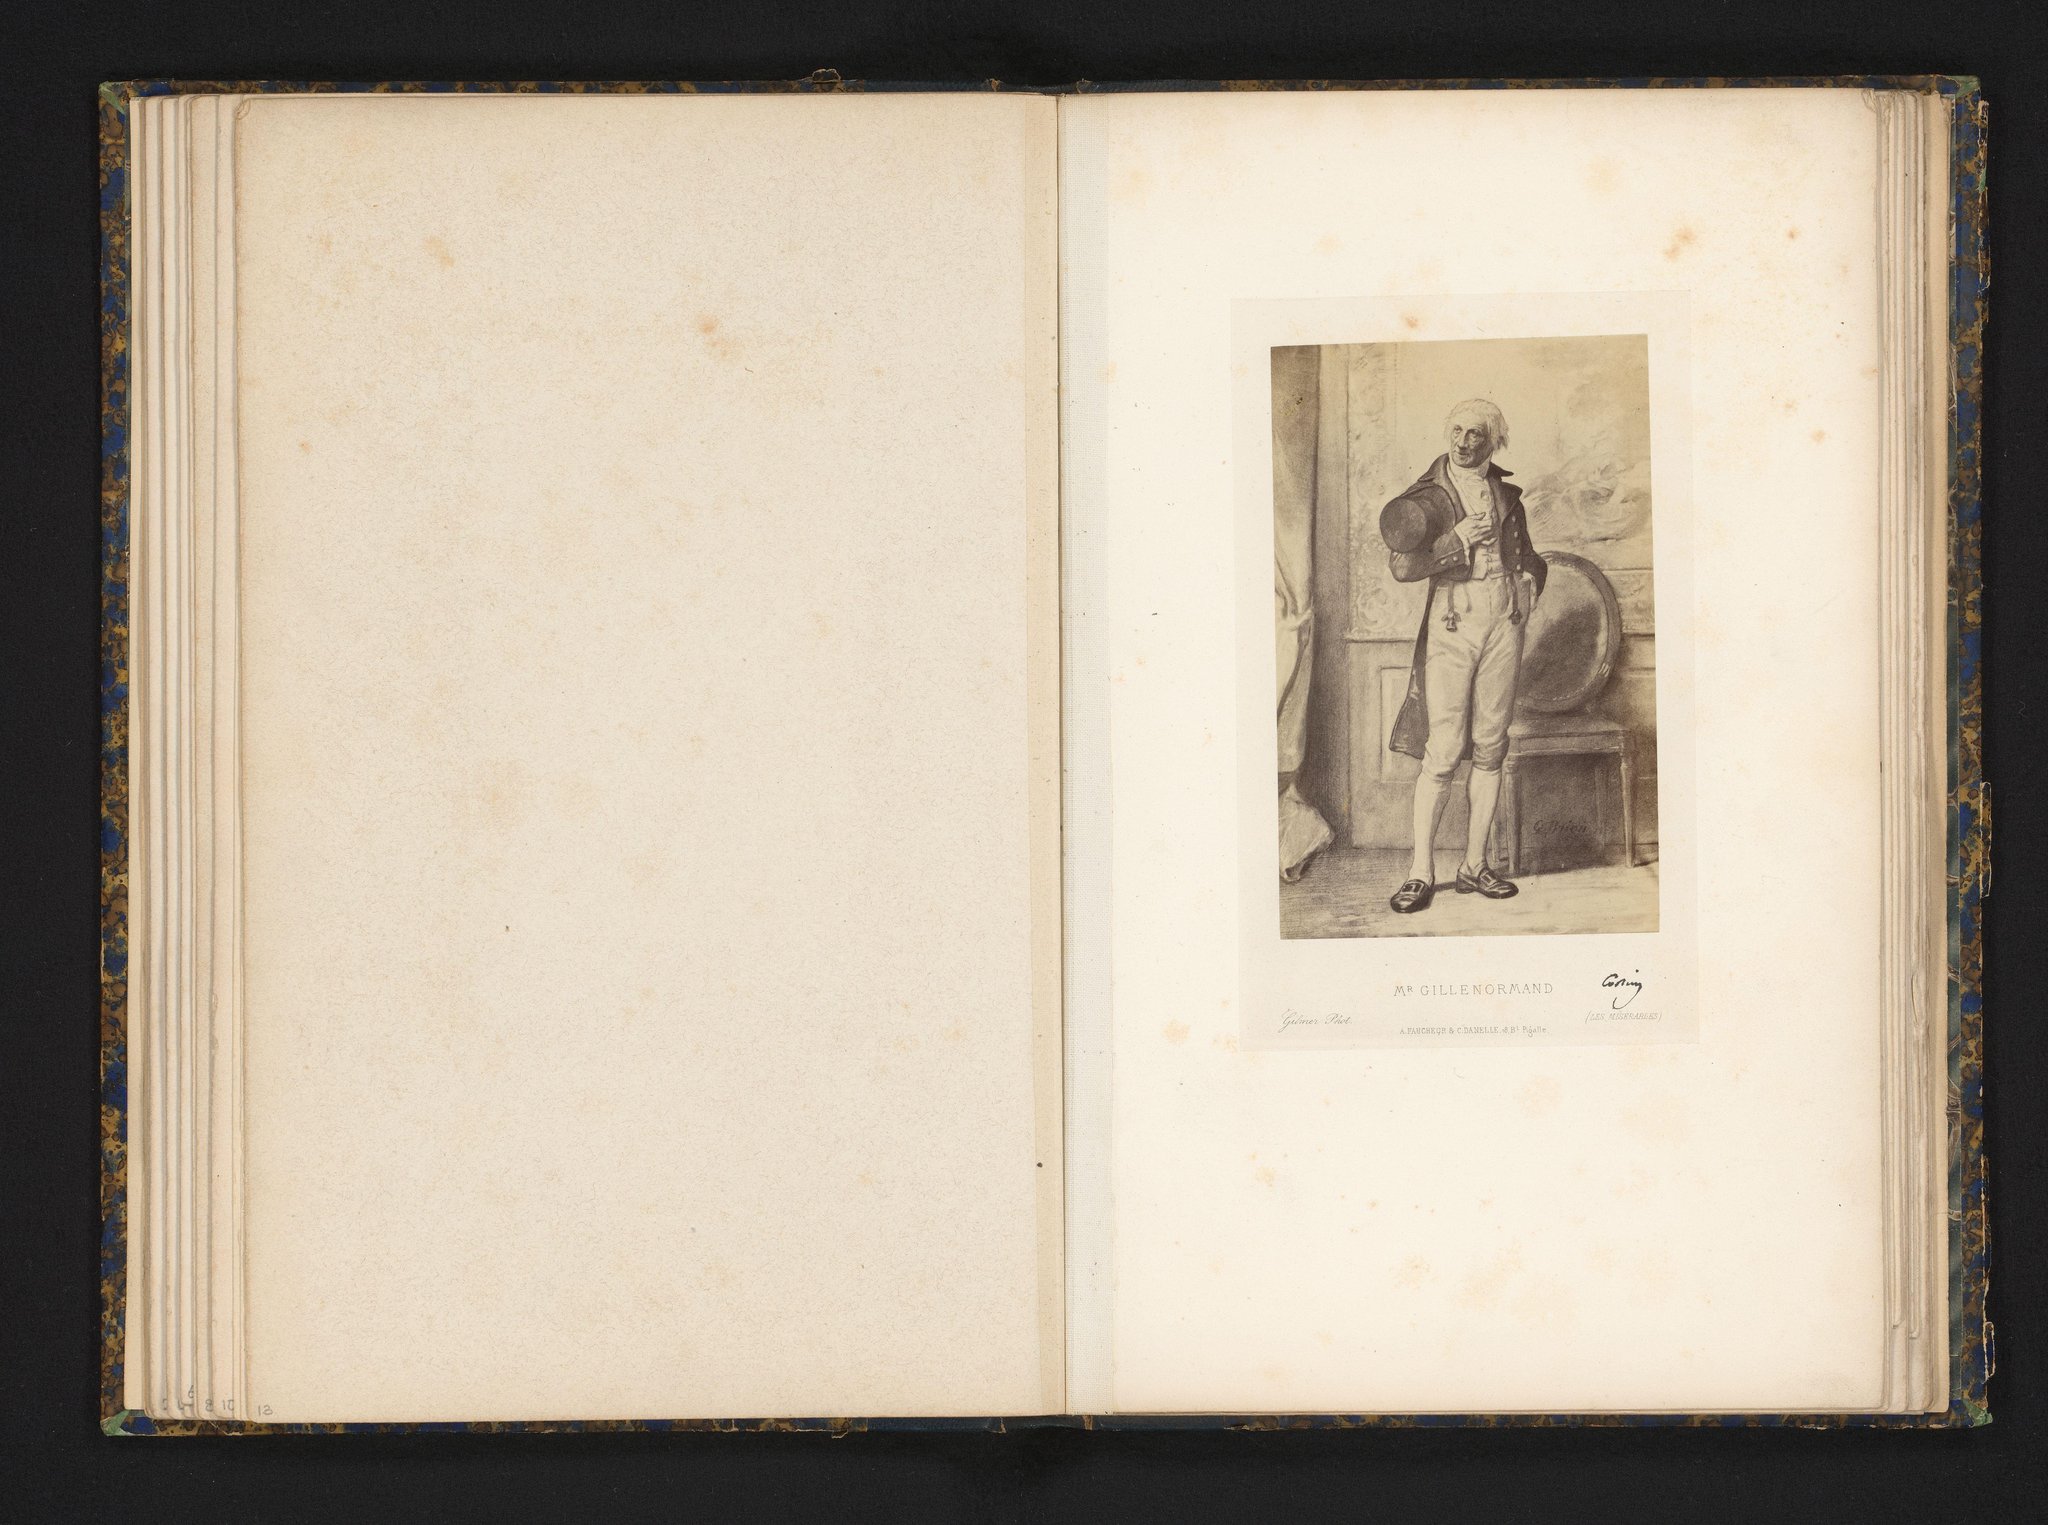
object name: page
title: Fotoreproductie van een tekening van meneer Gillenormand uit Les Misérables van Victor Hugo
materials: photographic support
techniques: albumen print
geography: paris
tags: literary characters and objects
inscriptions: inscription: ‘(LES MISÉRABLES)’, address: ‘A. FAUCHEUR & C. DANELLE, 18, Bt. Pigalle.’